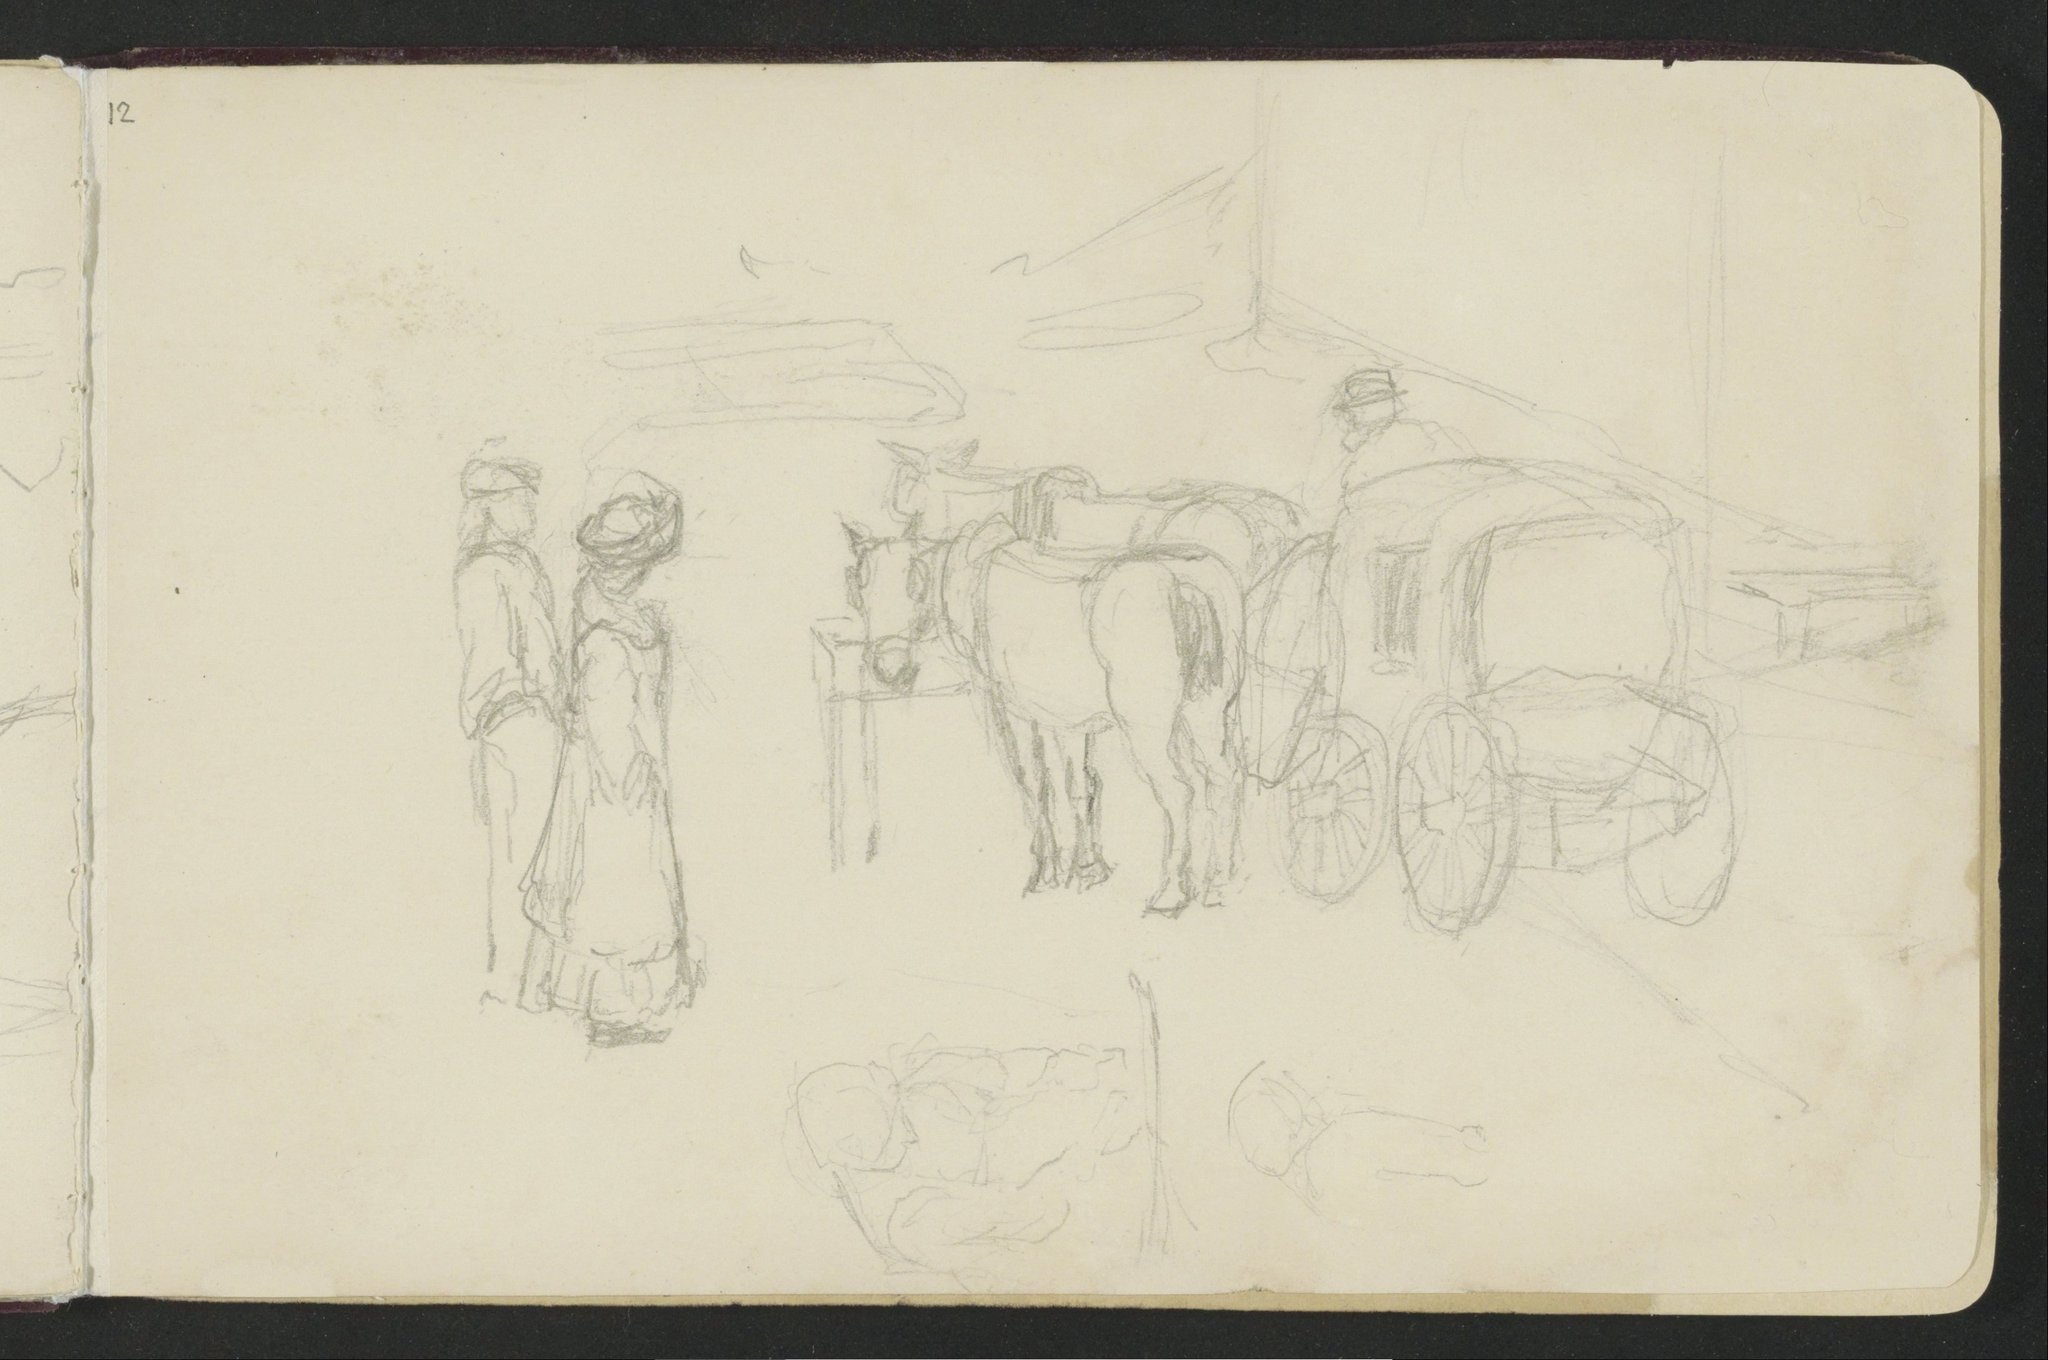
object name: sketchbook leaf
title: Paardenkoets en figuren op een straat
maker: jozef israëls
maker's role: draughtsman, painter, print maker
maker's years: 1824-1911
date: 1885-1911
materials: paper, pencil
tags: four-wheeled, animal-drawn vehicle, e.g.: cab, carriage, coach, street (+ city(-scape) with figures, staffage)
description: Tevens twee figuurstudies. Blad 12 recto uit een schetsboek met 26 bladen.